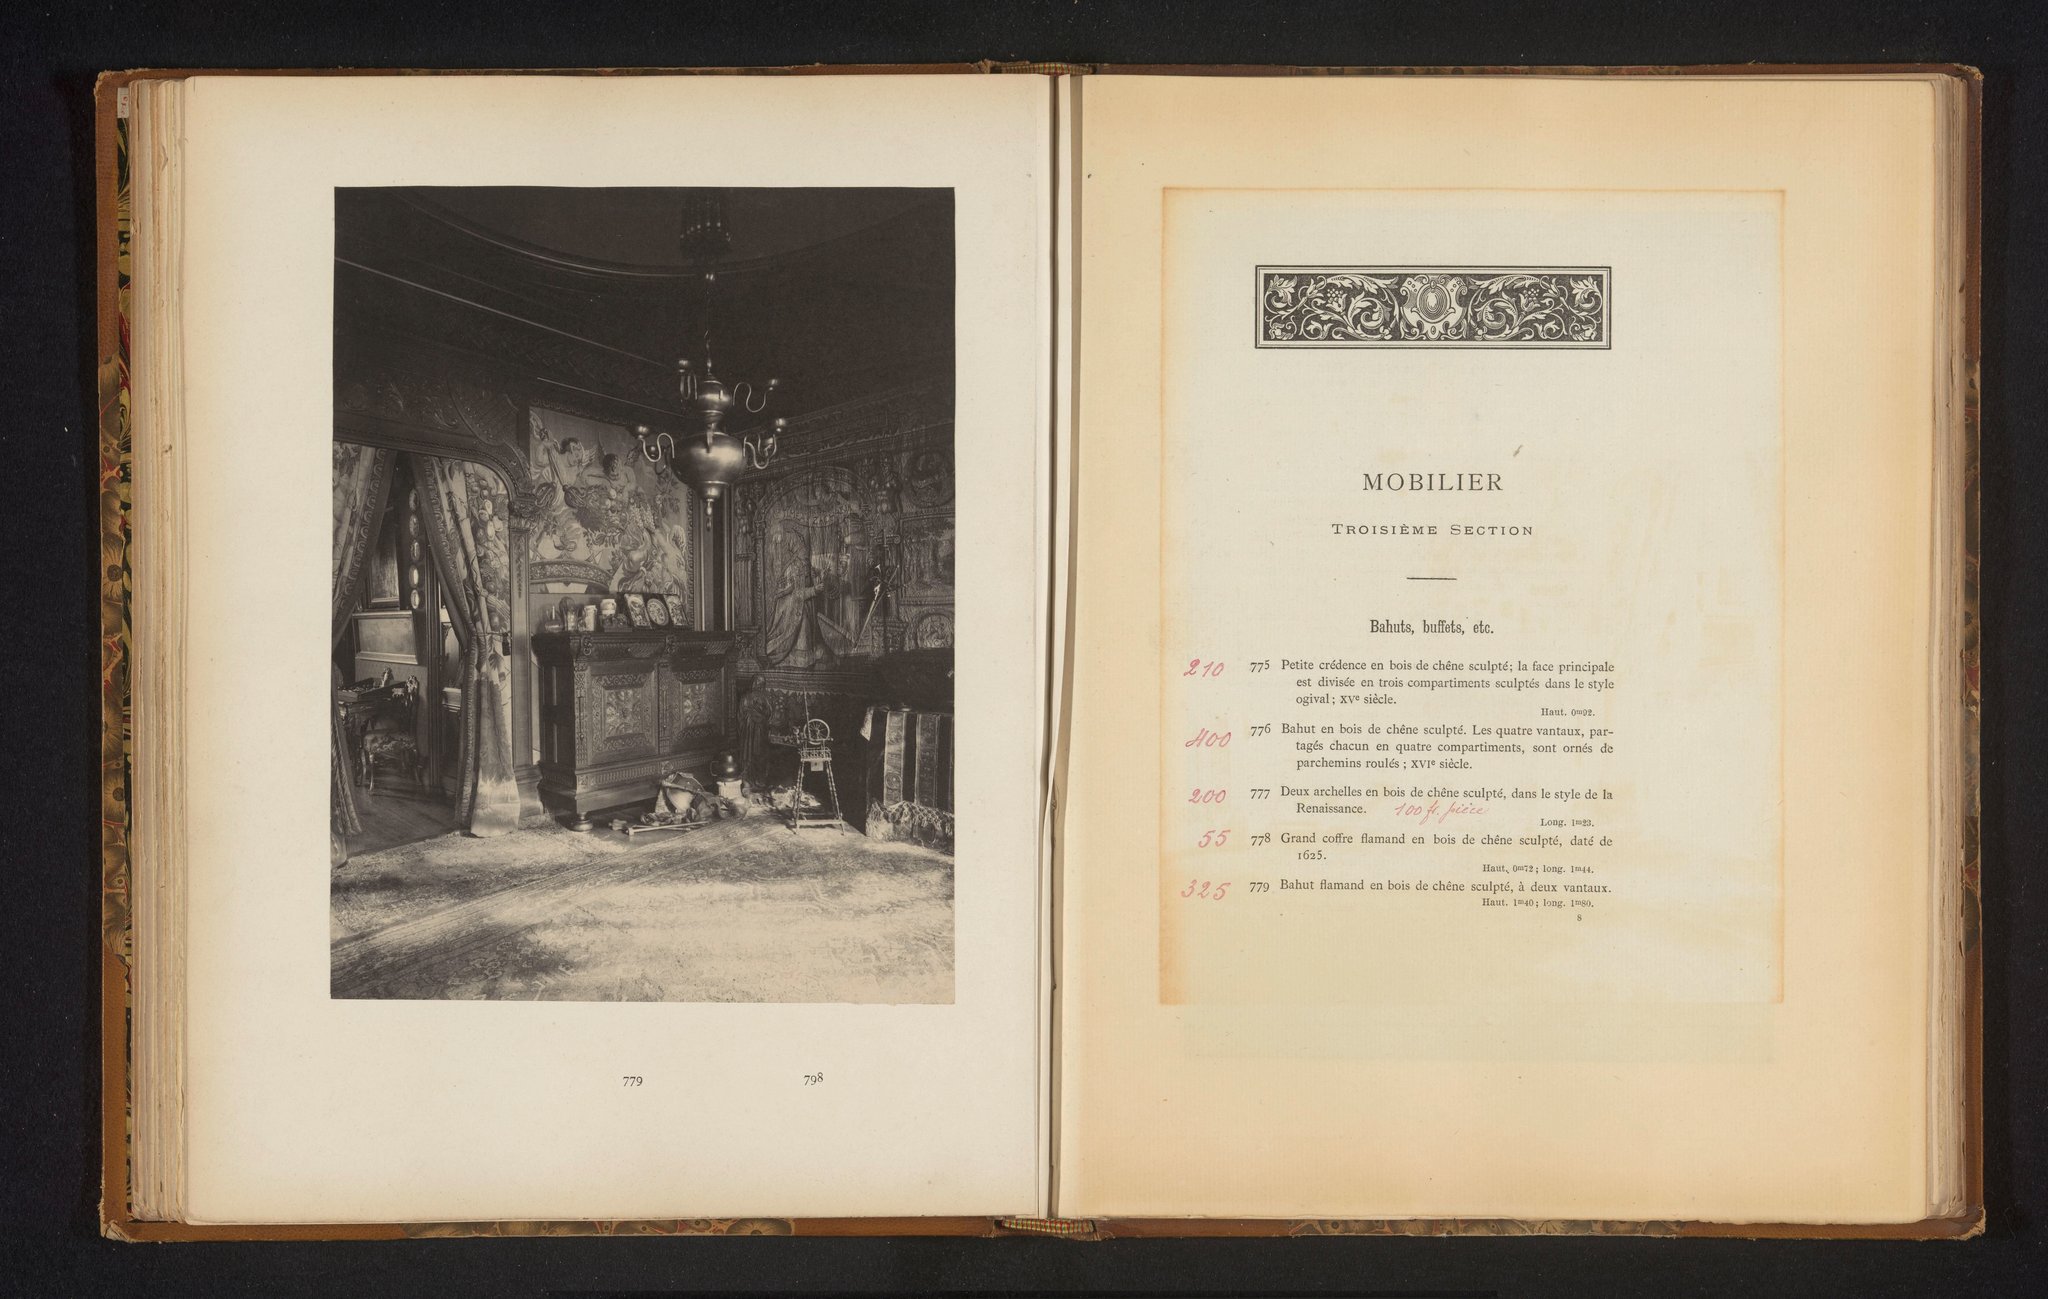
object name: page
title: Kamer in het huis van Antonin Terme met zijn collectie antiquiteiten, houten spinnewiel en een kast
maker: Anonymous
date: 1880-1885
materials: photographic support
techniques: platinum process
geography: liège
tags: art collection, art gallery, 'kunstschrank', other rooms